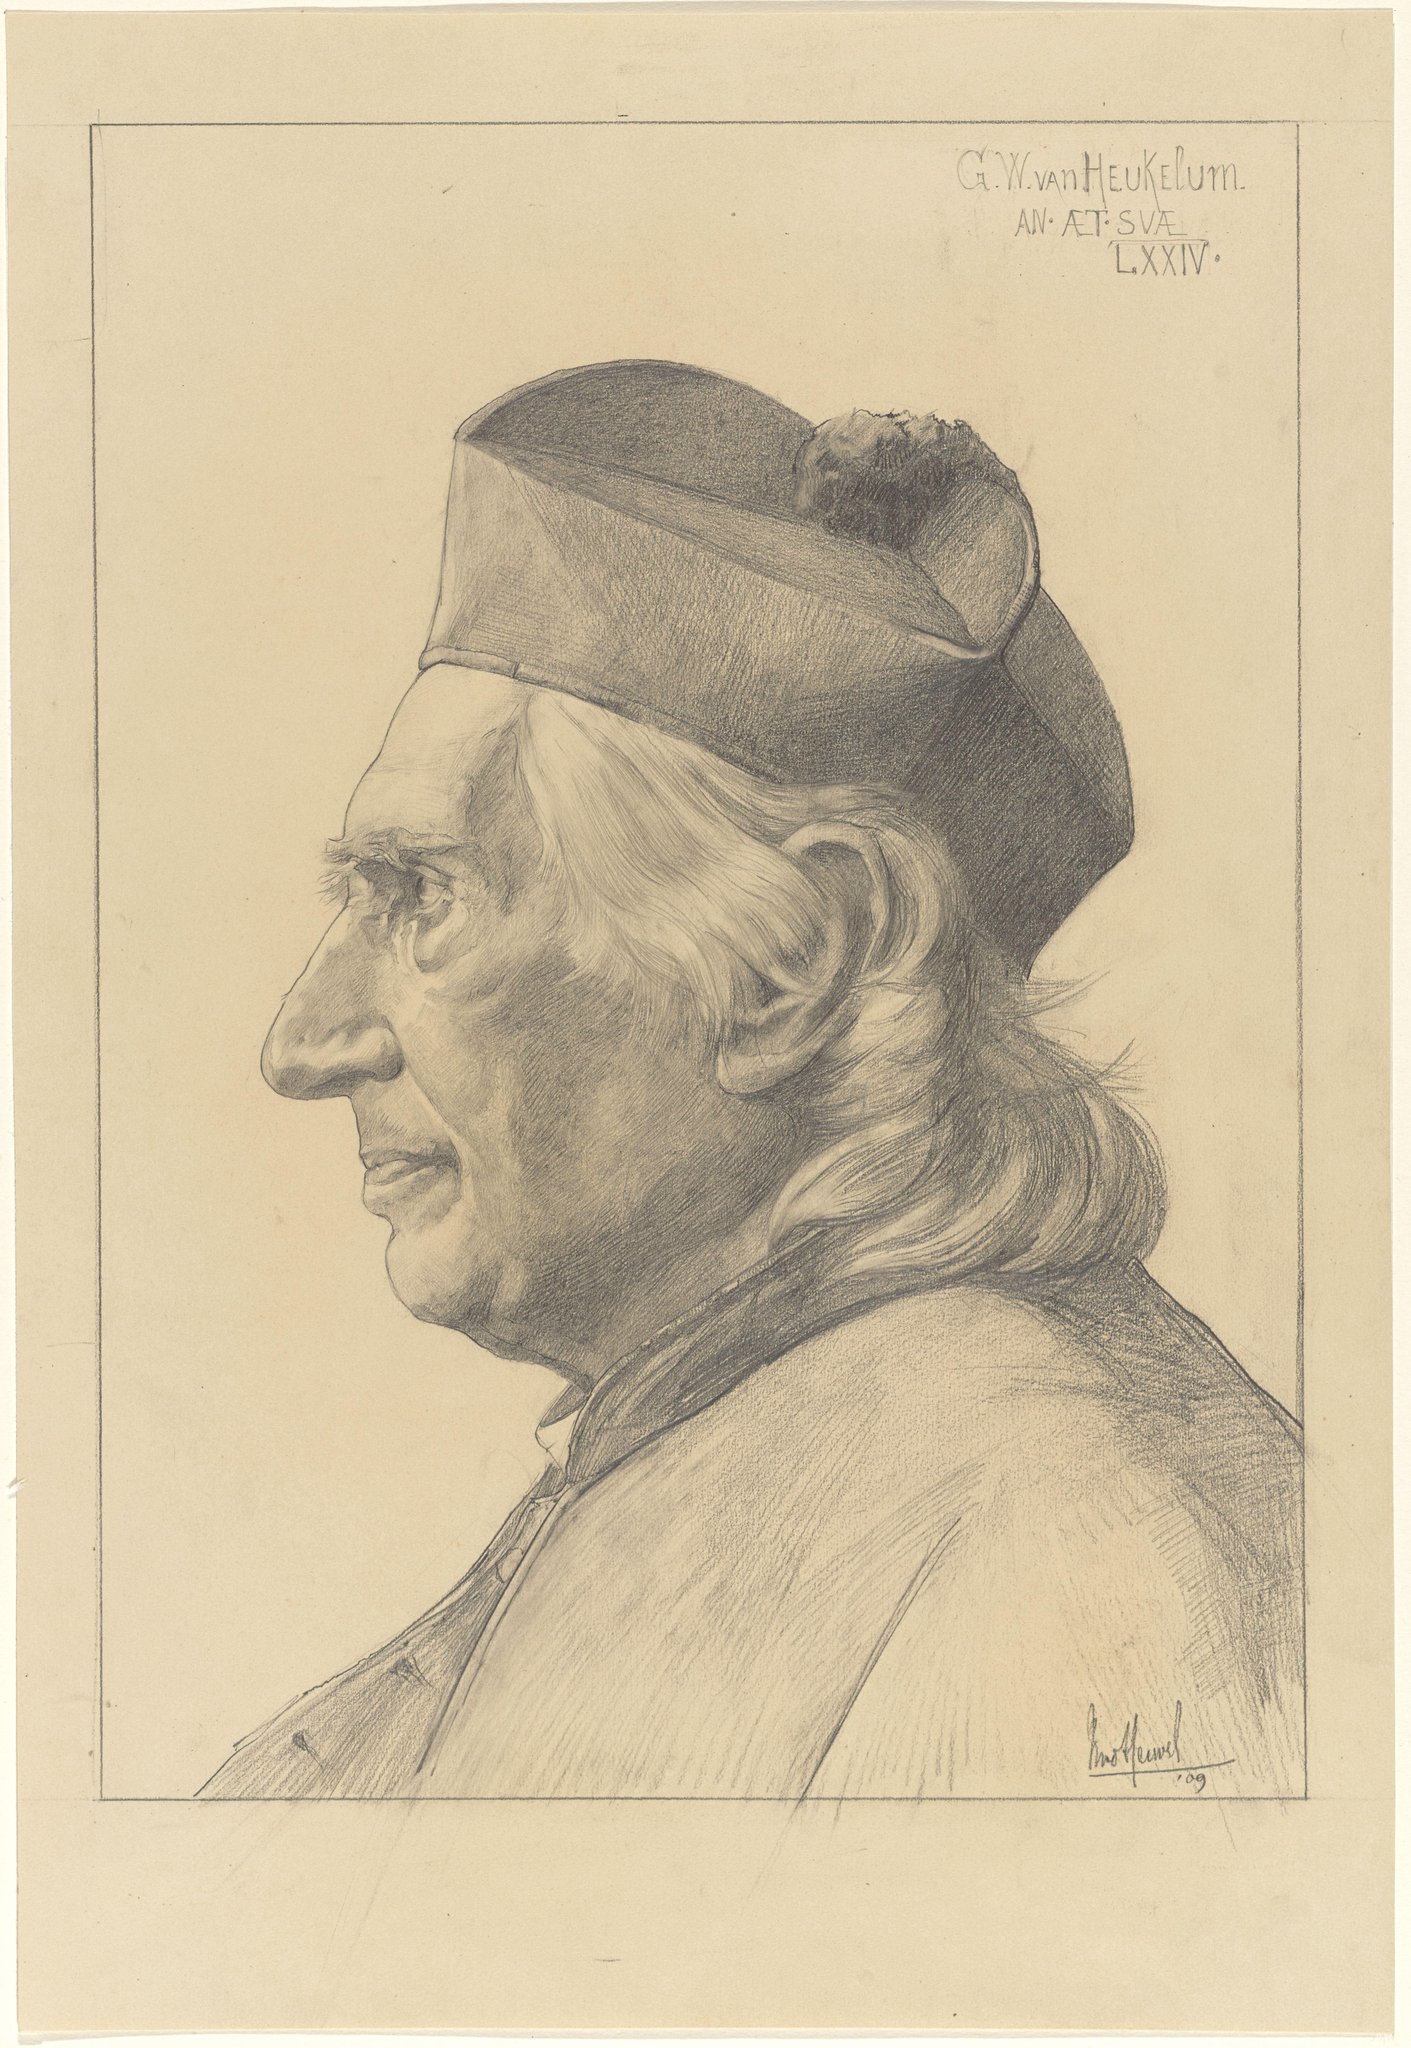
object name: drawing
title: Portret van Gijsbertus Wilhelmus van Heukelum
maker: willem van den heuvel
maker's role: draughtsman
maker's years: 1874-1925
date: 1909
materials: paper, pencil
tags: priest, gijsbertus wilhelmus van heukelum, priest (roman catholic), historical persons